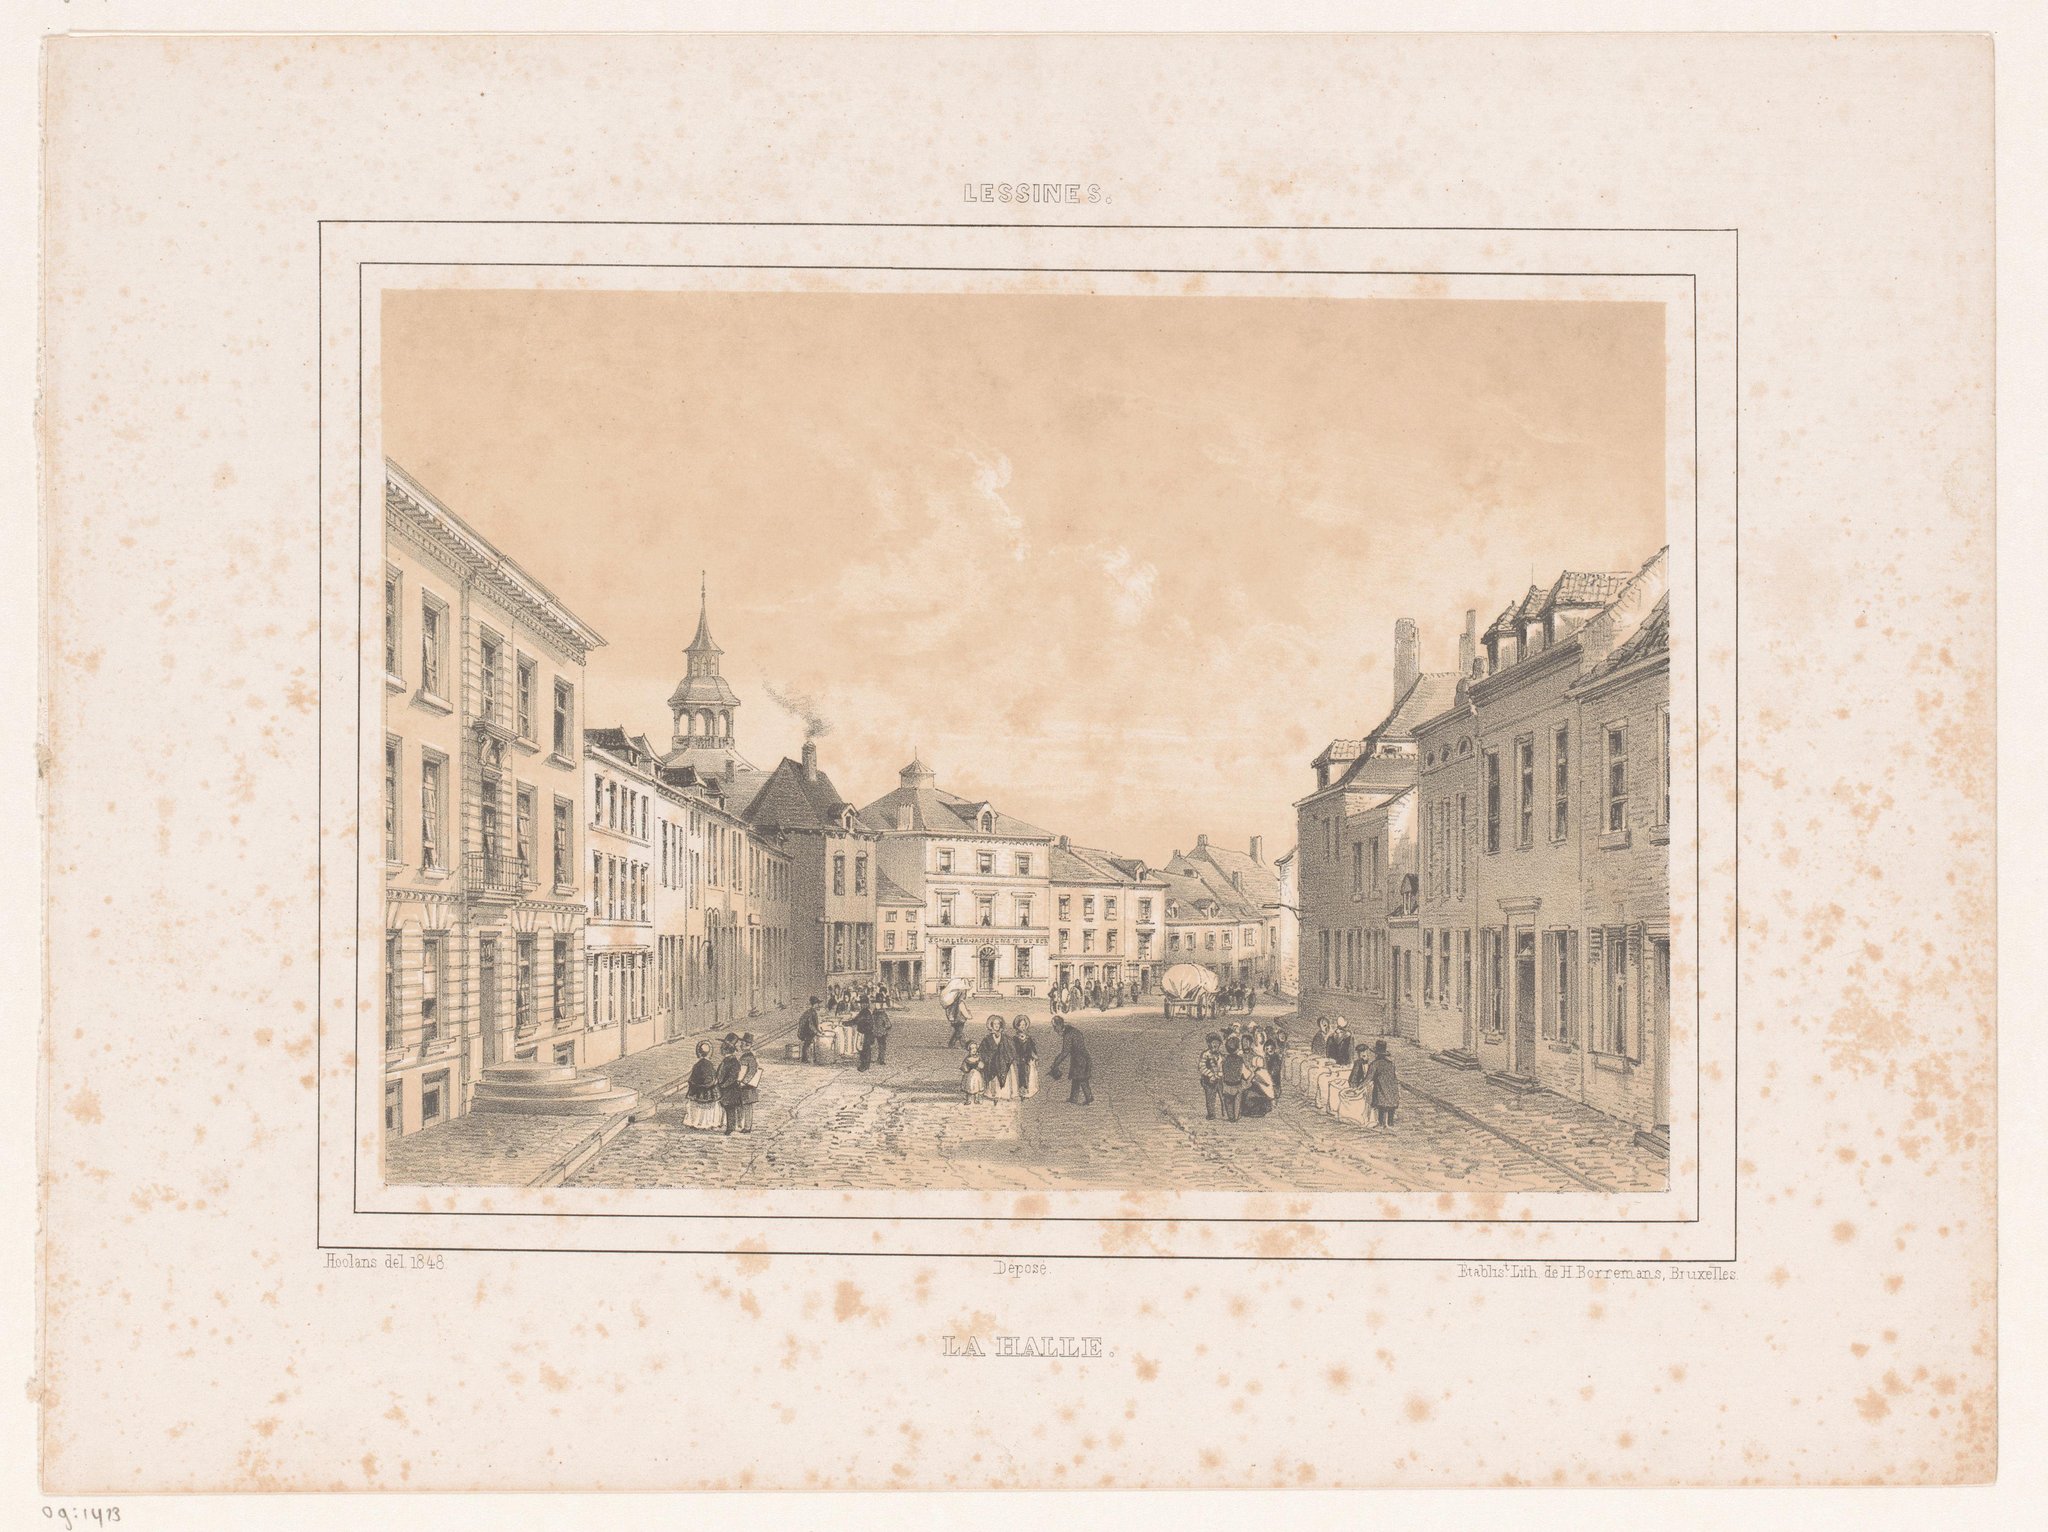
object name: print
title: Lessines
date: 1848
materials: paper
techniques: tone lithography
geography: brussels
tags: street, city-view in general; 'veduta' (+ city(-scape) with figures, staffage)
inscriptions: collector's mark: Lugt 2228, : ‘Déposé’